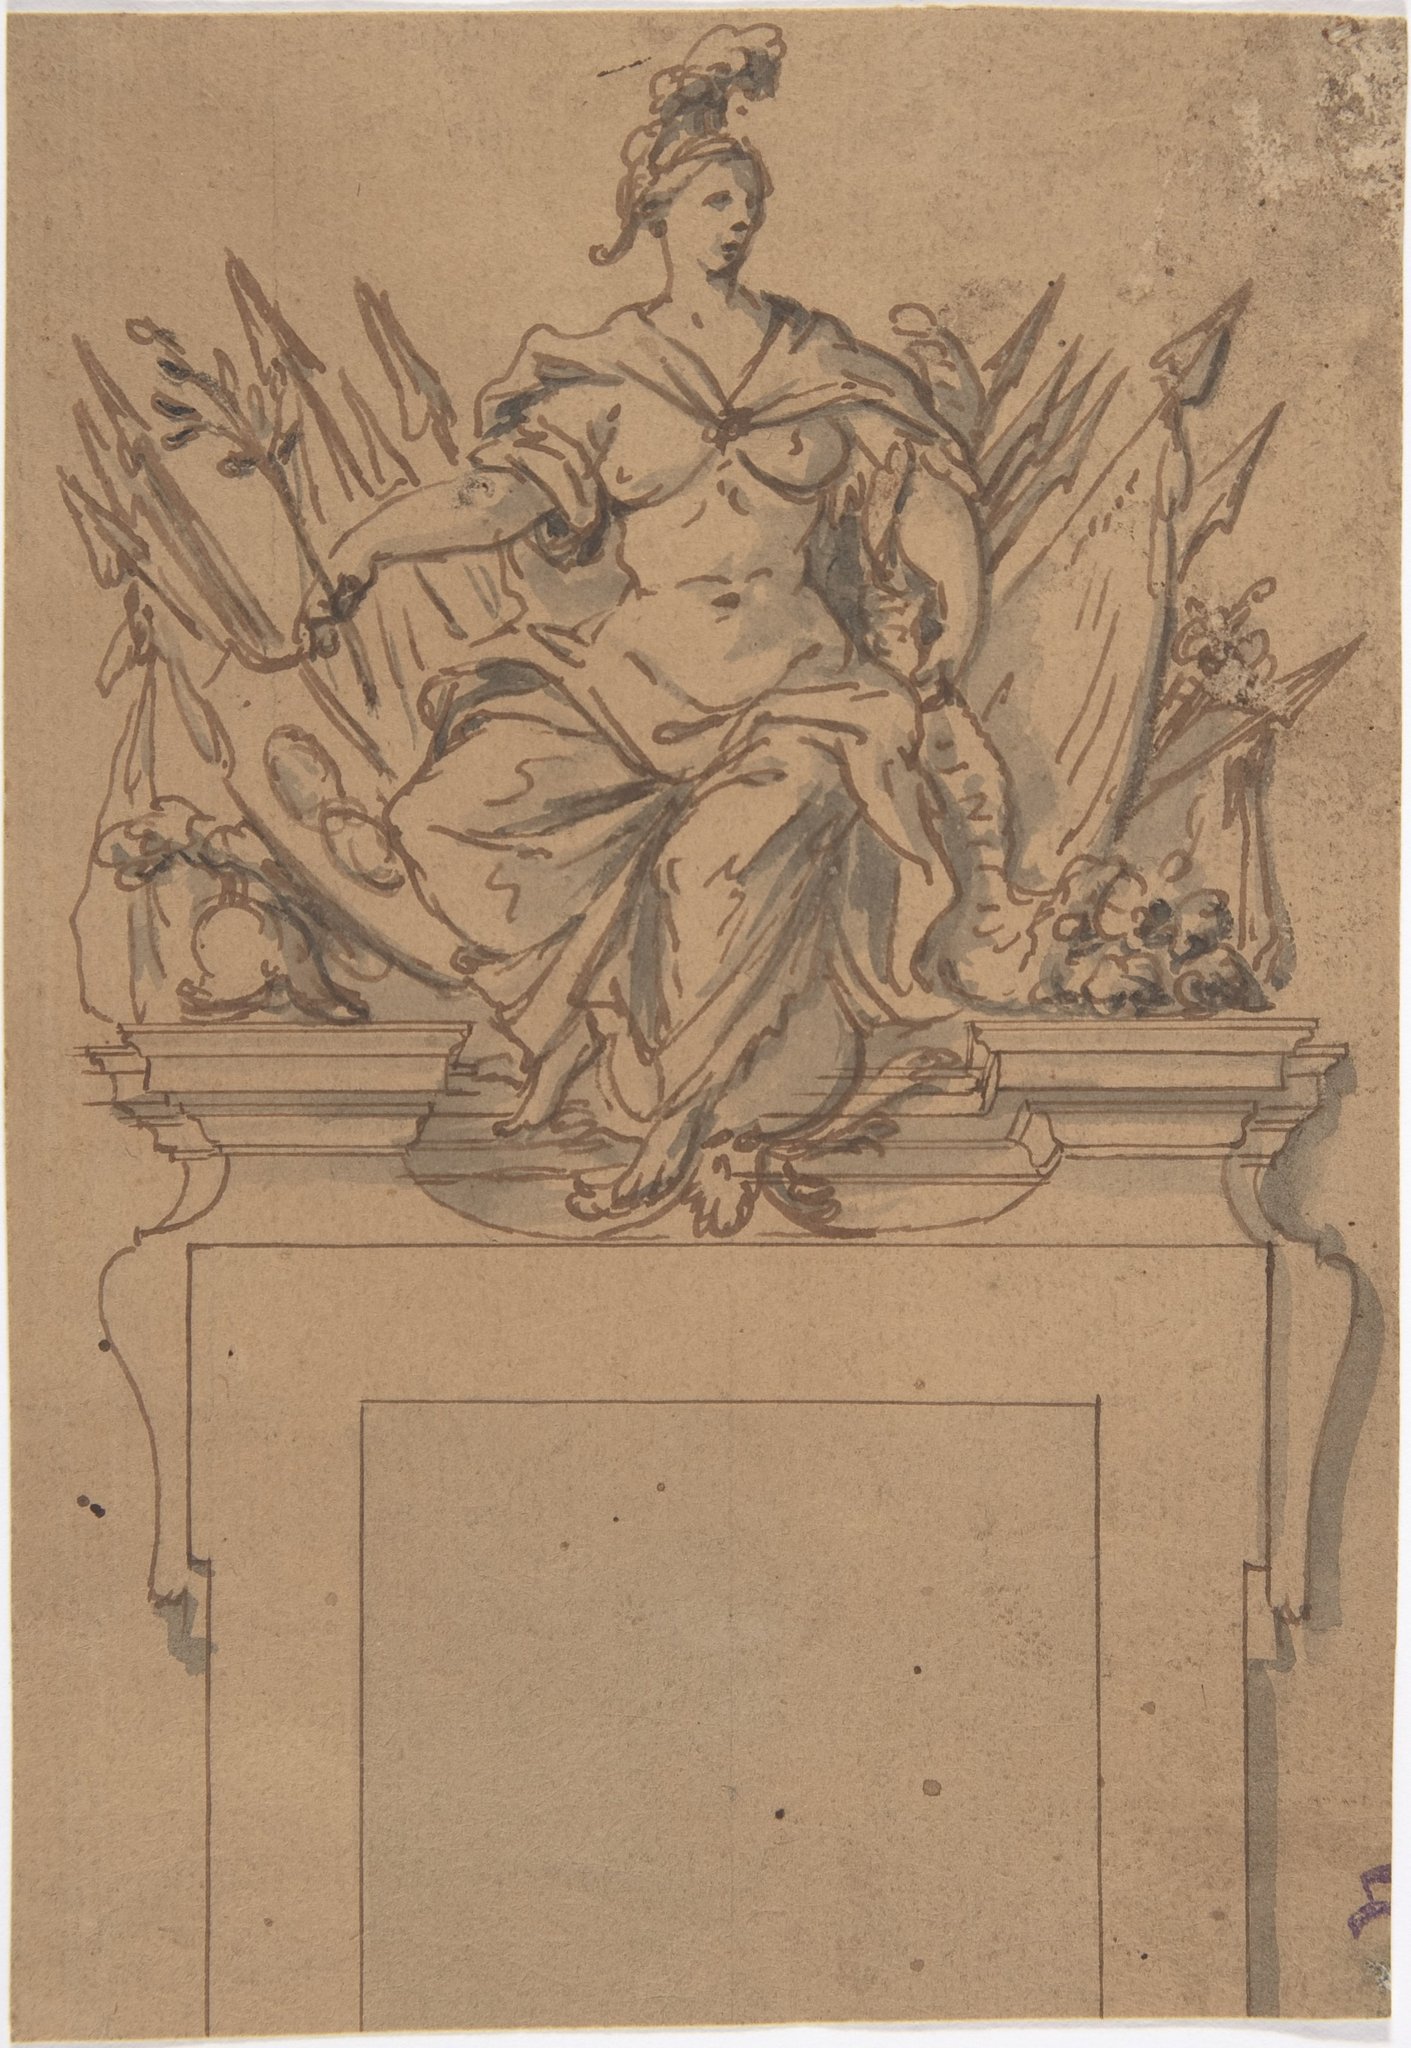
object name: drawing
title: Design for an Overdoor or Chimney Piece with an Armorial Trophy and the personification of Victory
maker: anonymous, french, 18th century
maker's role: artist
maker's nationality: french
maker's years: 1700-1800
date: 1701-1800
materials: ink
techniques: pen, wash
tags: weapons,women